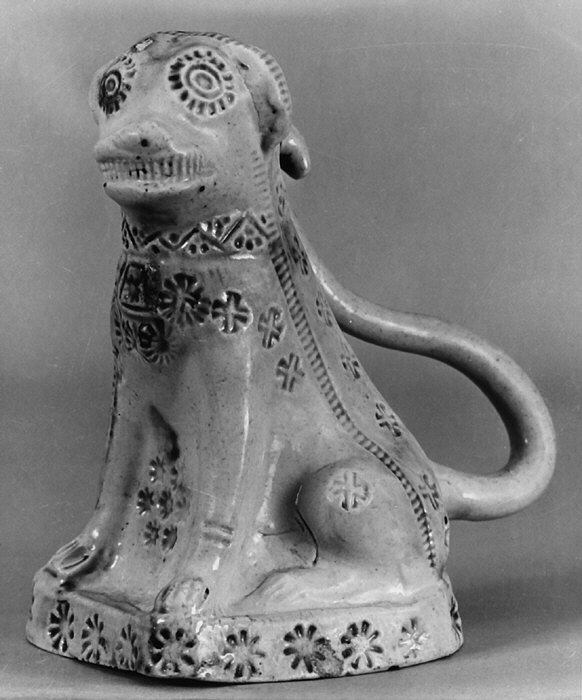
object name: figure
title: Dog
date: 1750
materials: stoneware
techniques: salt glaze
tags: dogs